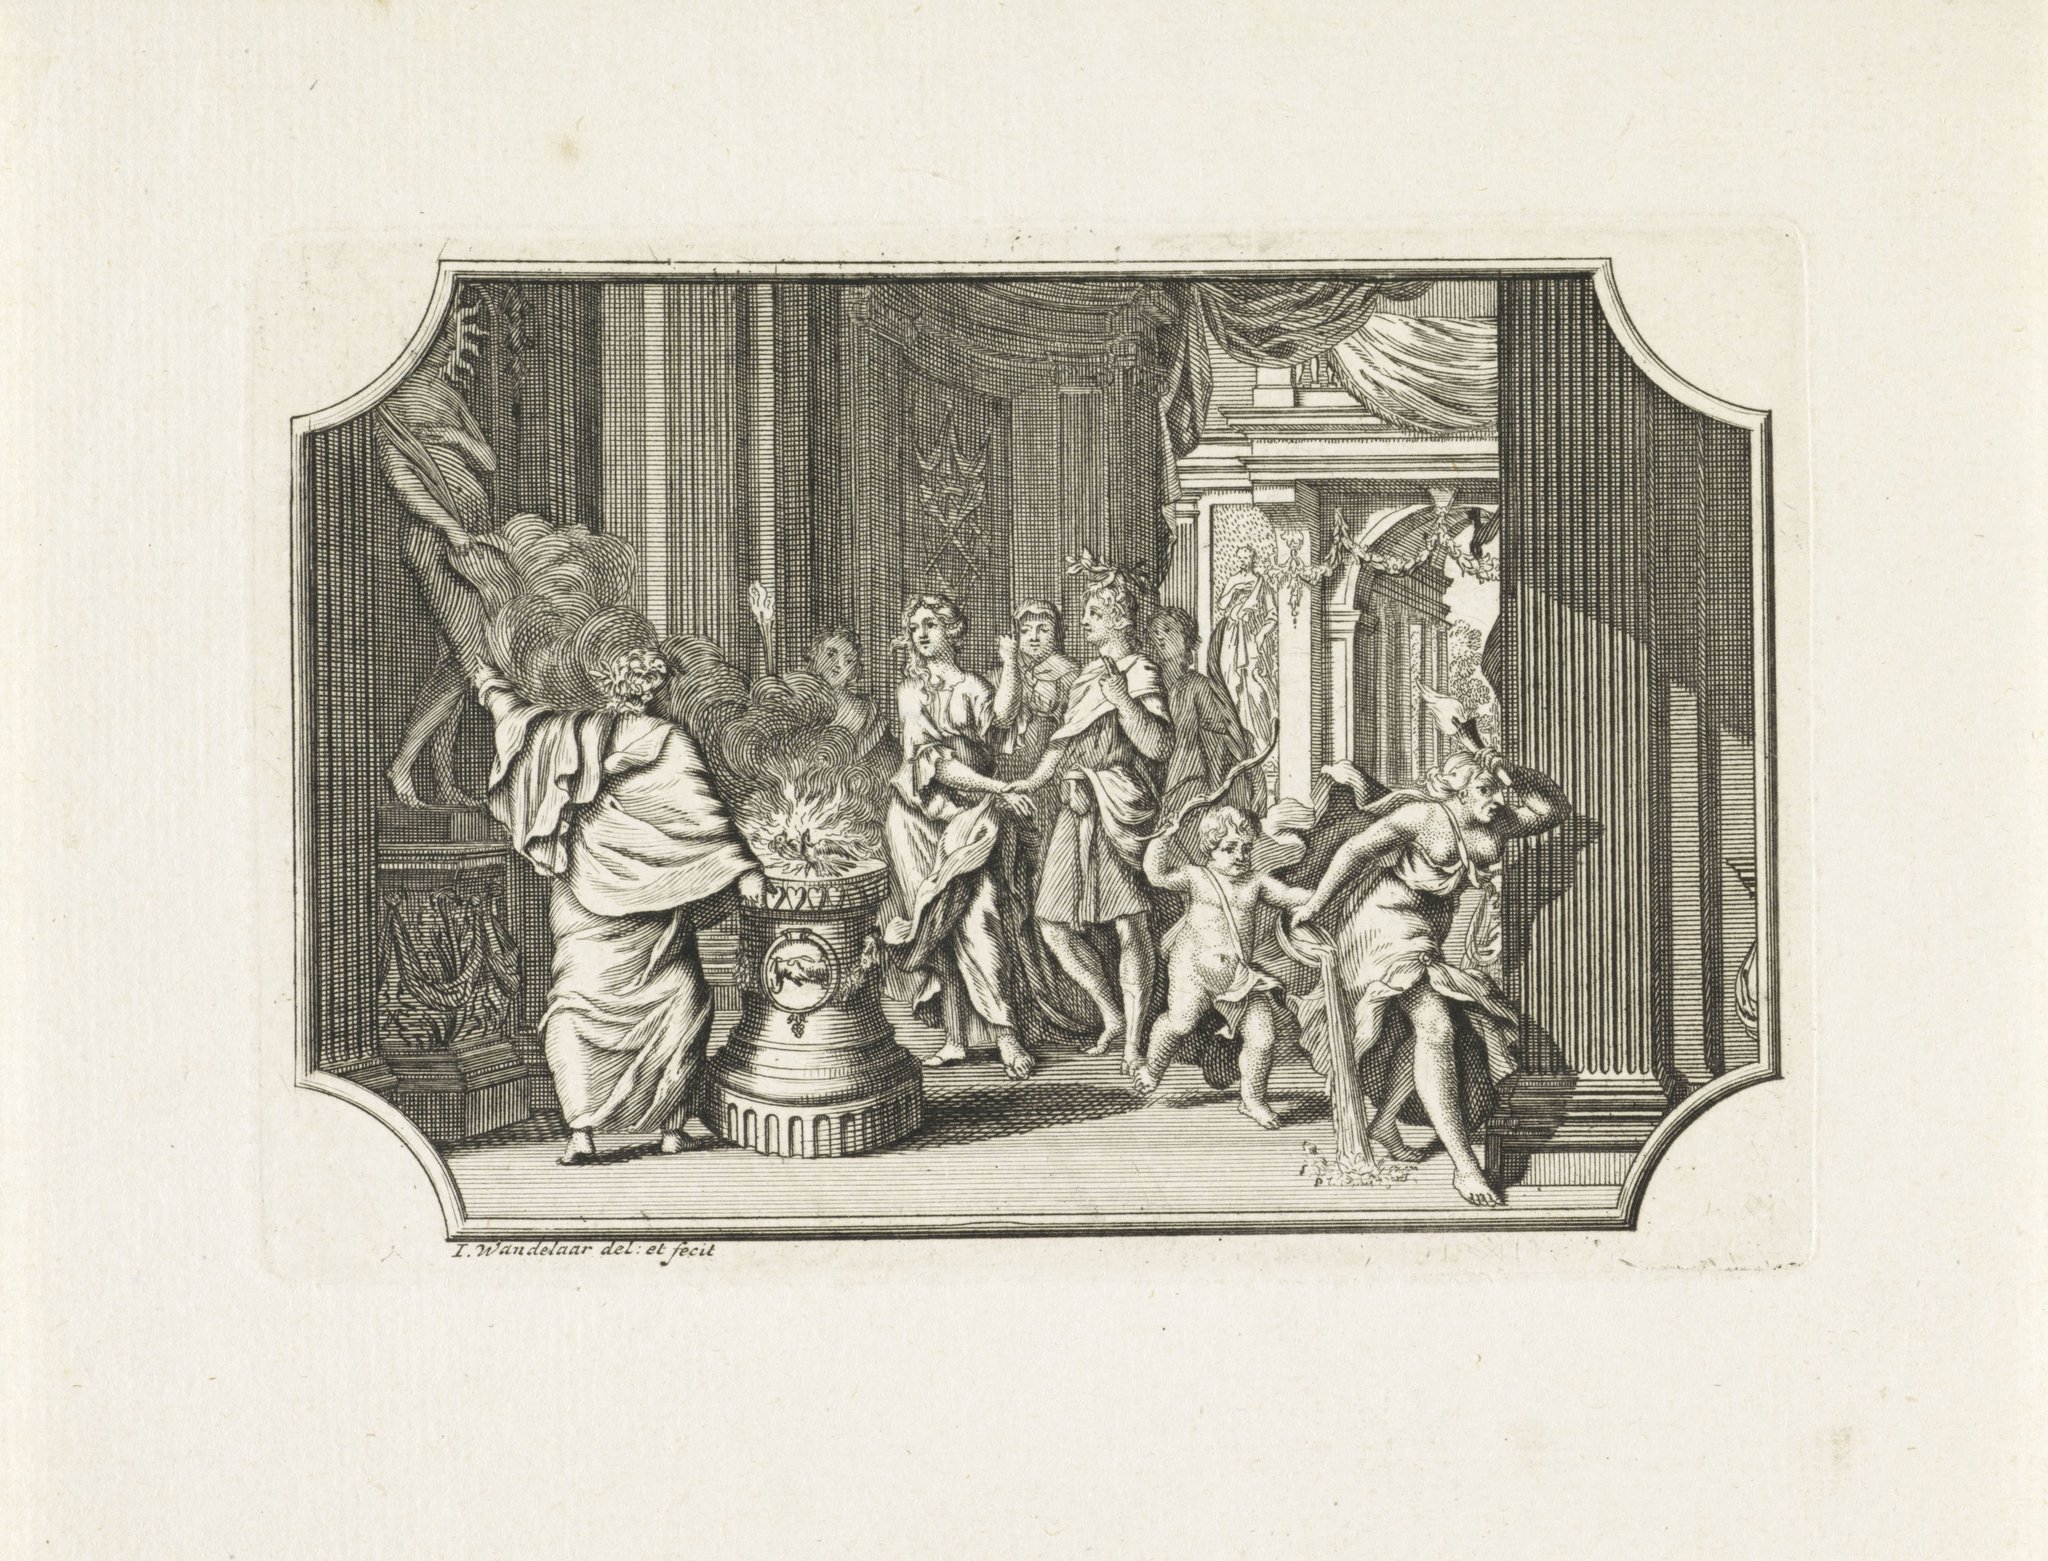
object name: marriage print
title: Huwelijkspaar bij een offerzuil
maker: jan wandelaar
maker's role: draughtsman, print maker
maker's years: 1690-1759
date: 1710-1759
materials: paper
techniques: engraving, etching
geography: northern netherlands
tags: envy; 'invidia' (ripa) ~ personification of one of the seven deadly sins, marriage, married couple, 'matrimonium', (story of) cupid, amor (eros), sacrifice ~ non-christian religions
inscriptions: collector's mark: Lugt 2228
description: Vooraan staat een priester bij een offerzuil in een tempel. Op de zuil worden twee duiven verbrand en de rook stijgt op in de richting van een beeld dat de liefde symboliseert. De zuil is versierd met twee ineengesloten handen als symbool van verbondenheid en harten als liefdessymbolen. Achter de zuil staat een jong paar dat trouw aan elkaar belooft. Rechtsvoor jaagt Amor met zijn boog de personificatie van Afgunst met water de tempel uit.